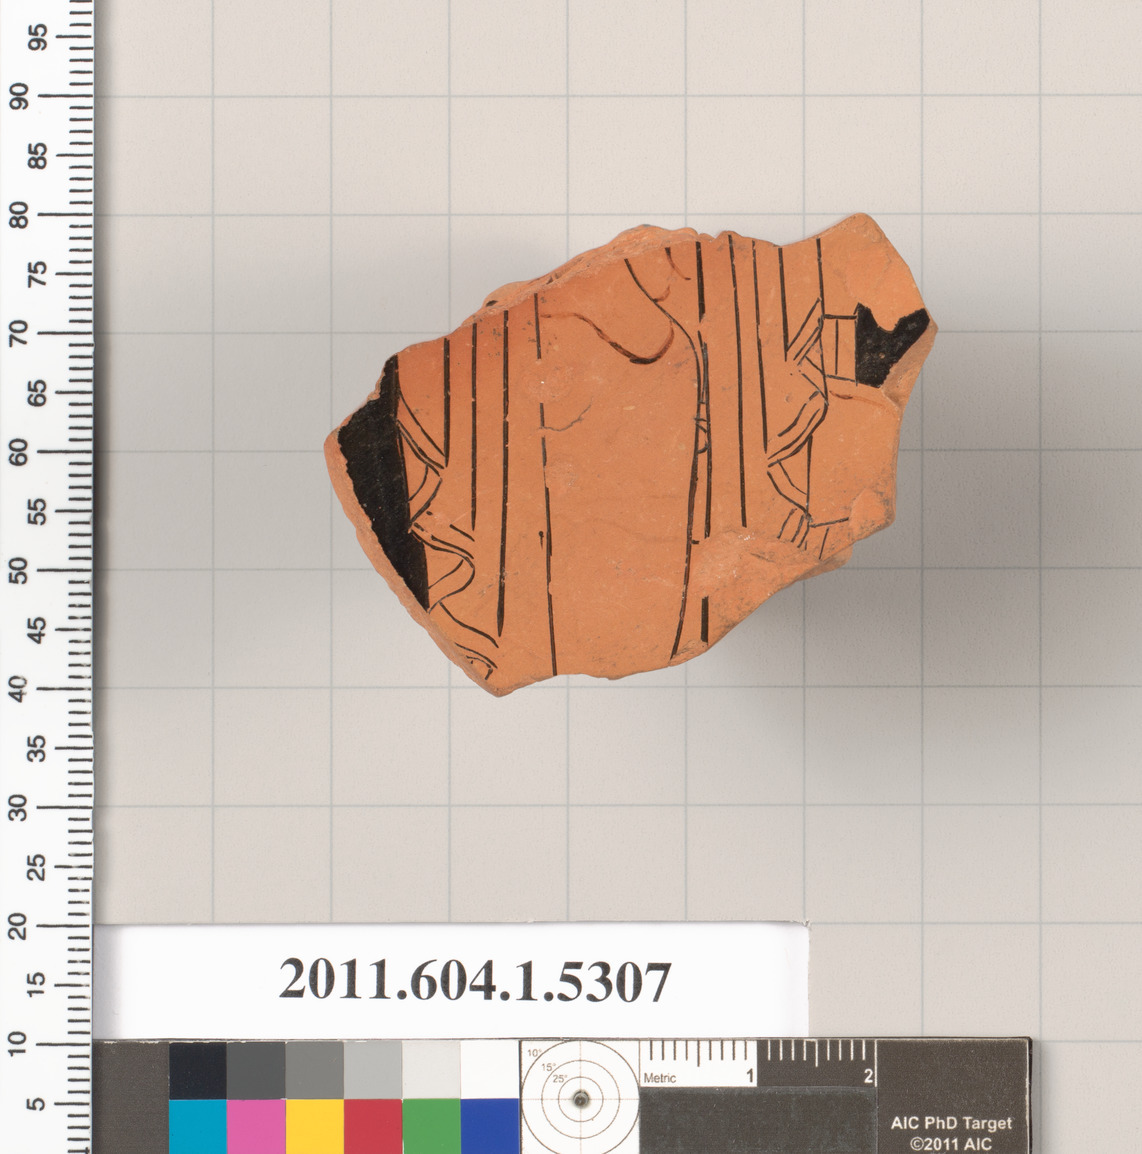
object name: kylix fragment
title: Terracotta fragment of a kylix (drinking cup)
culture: greek, attic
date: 490-480 BCE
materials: terracotta